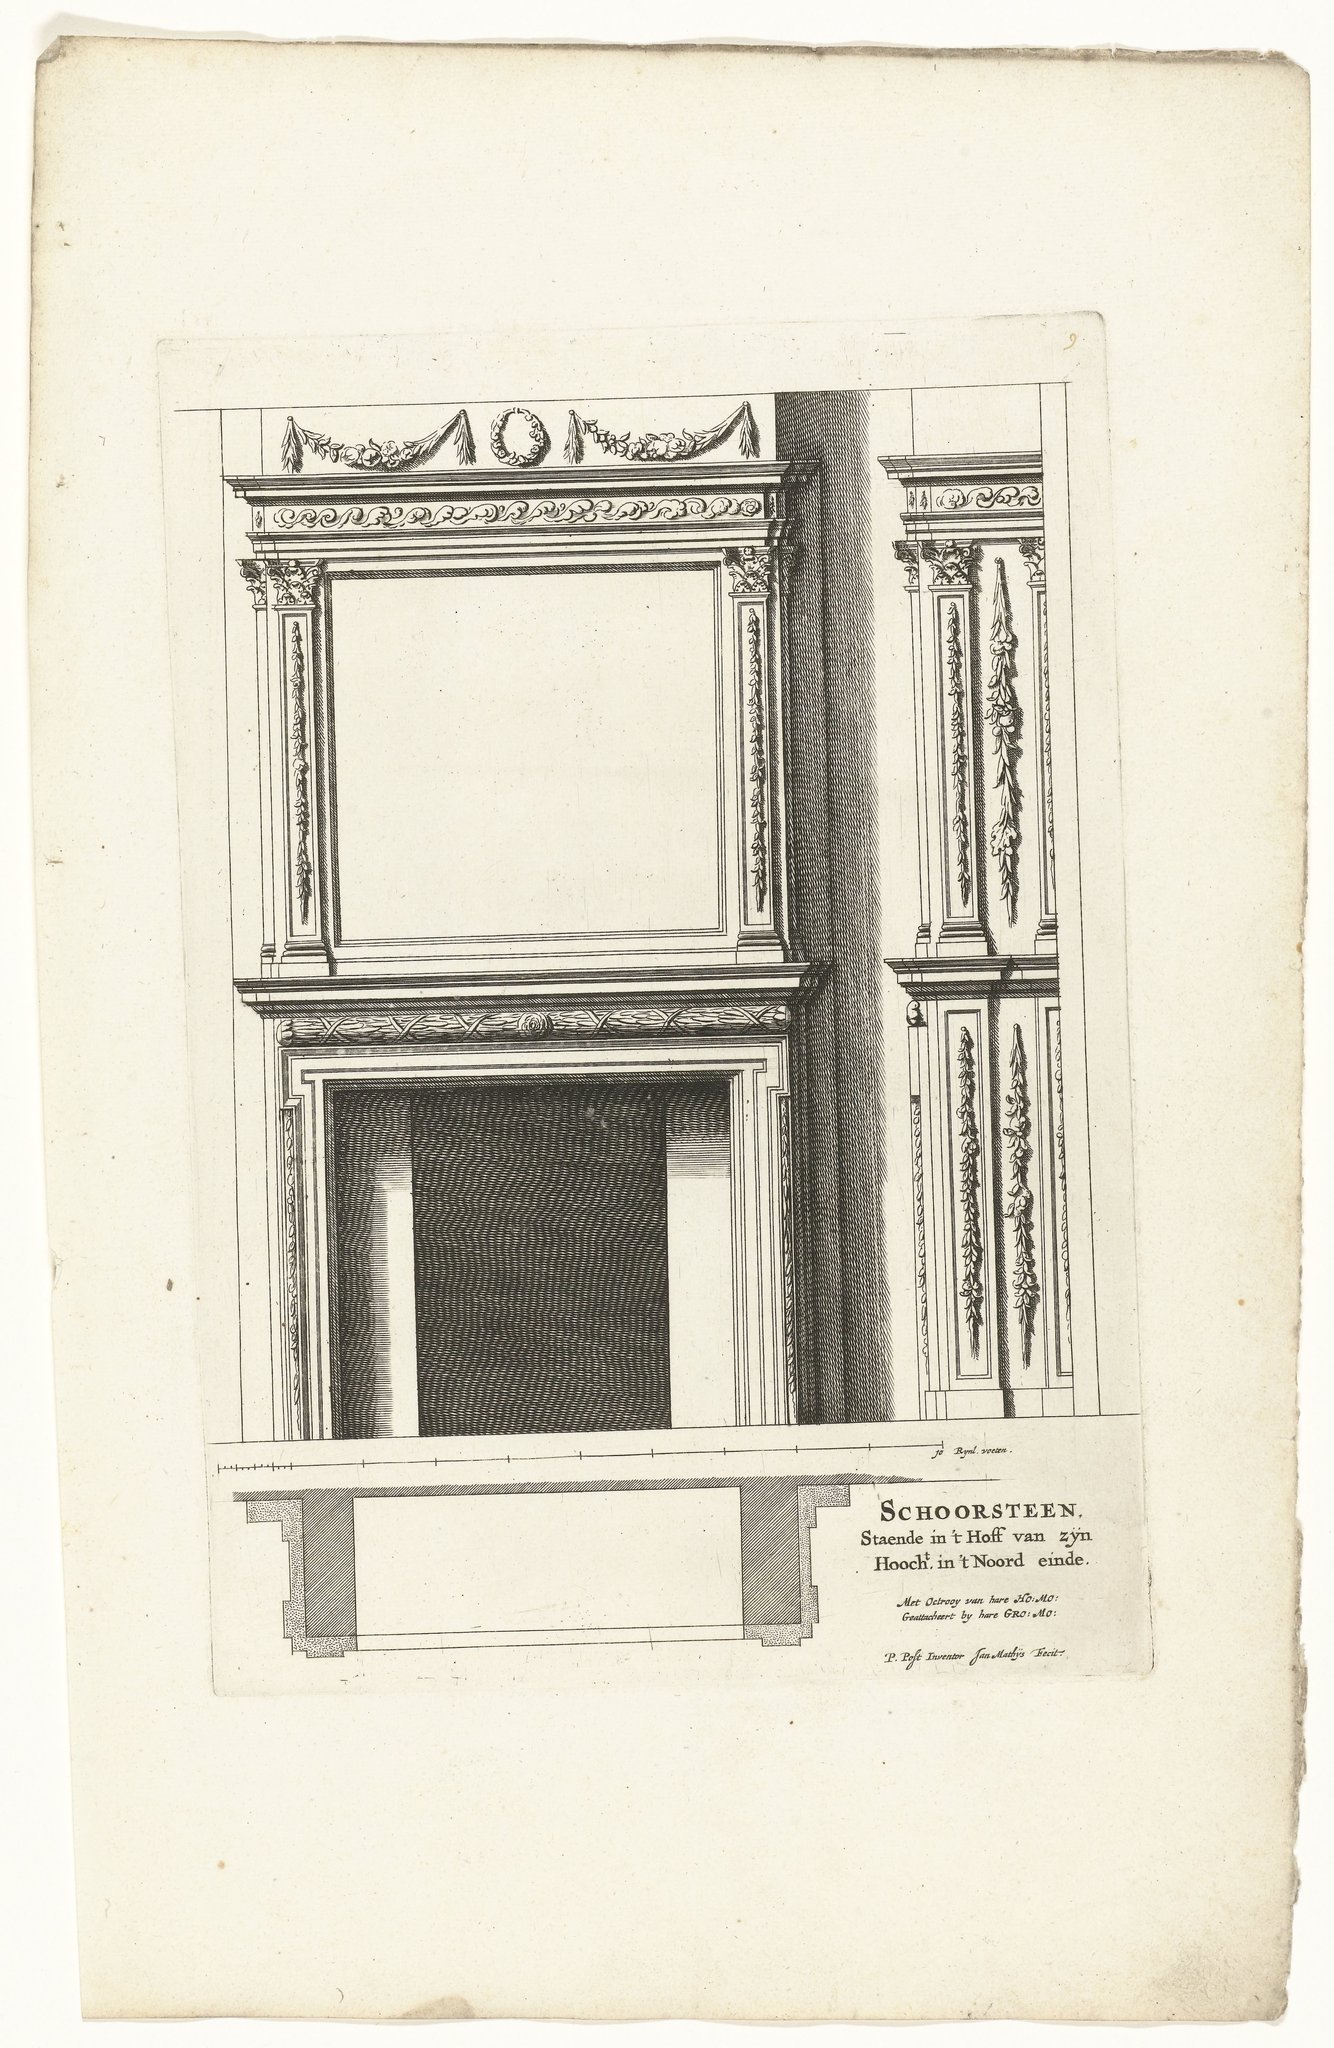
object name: ornament print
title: Schoorsteen-Wercken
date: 1664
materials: paper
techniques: engraving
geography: the hague